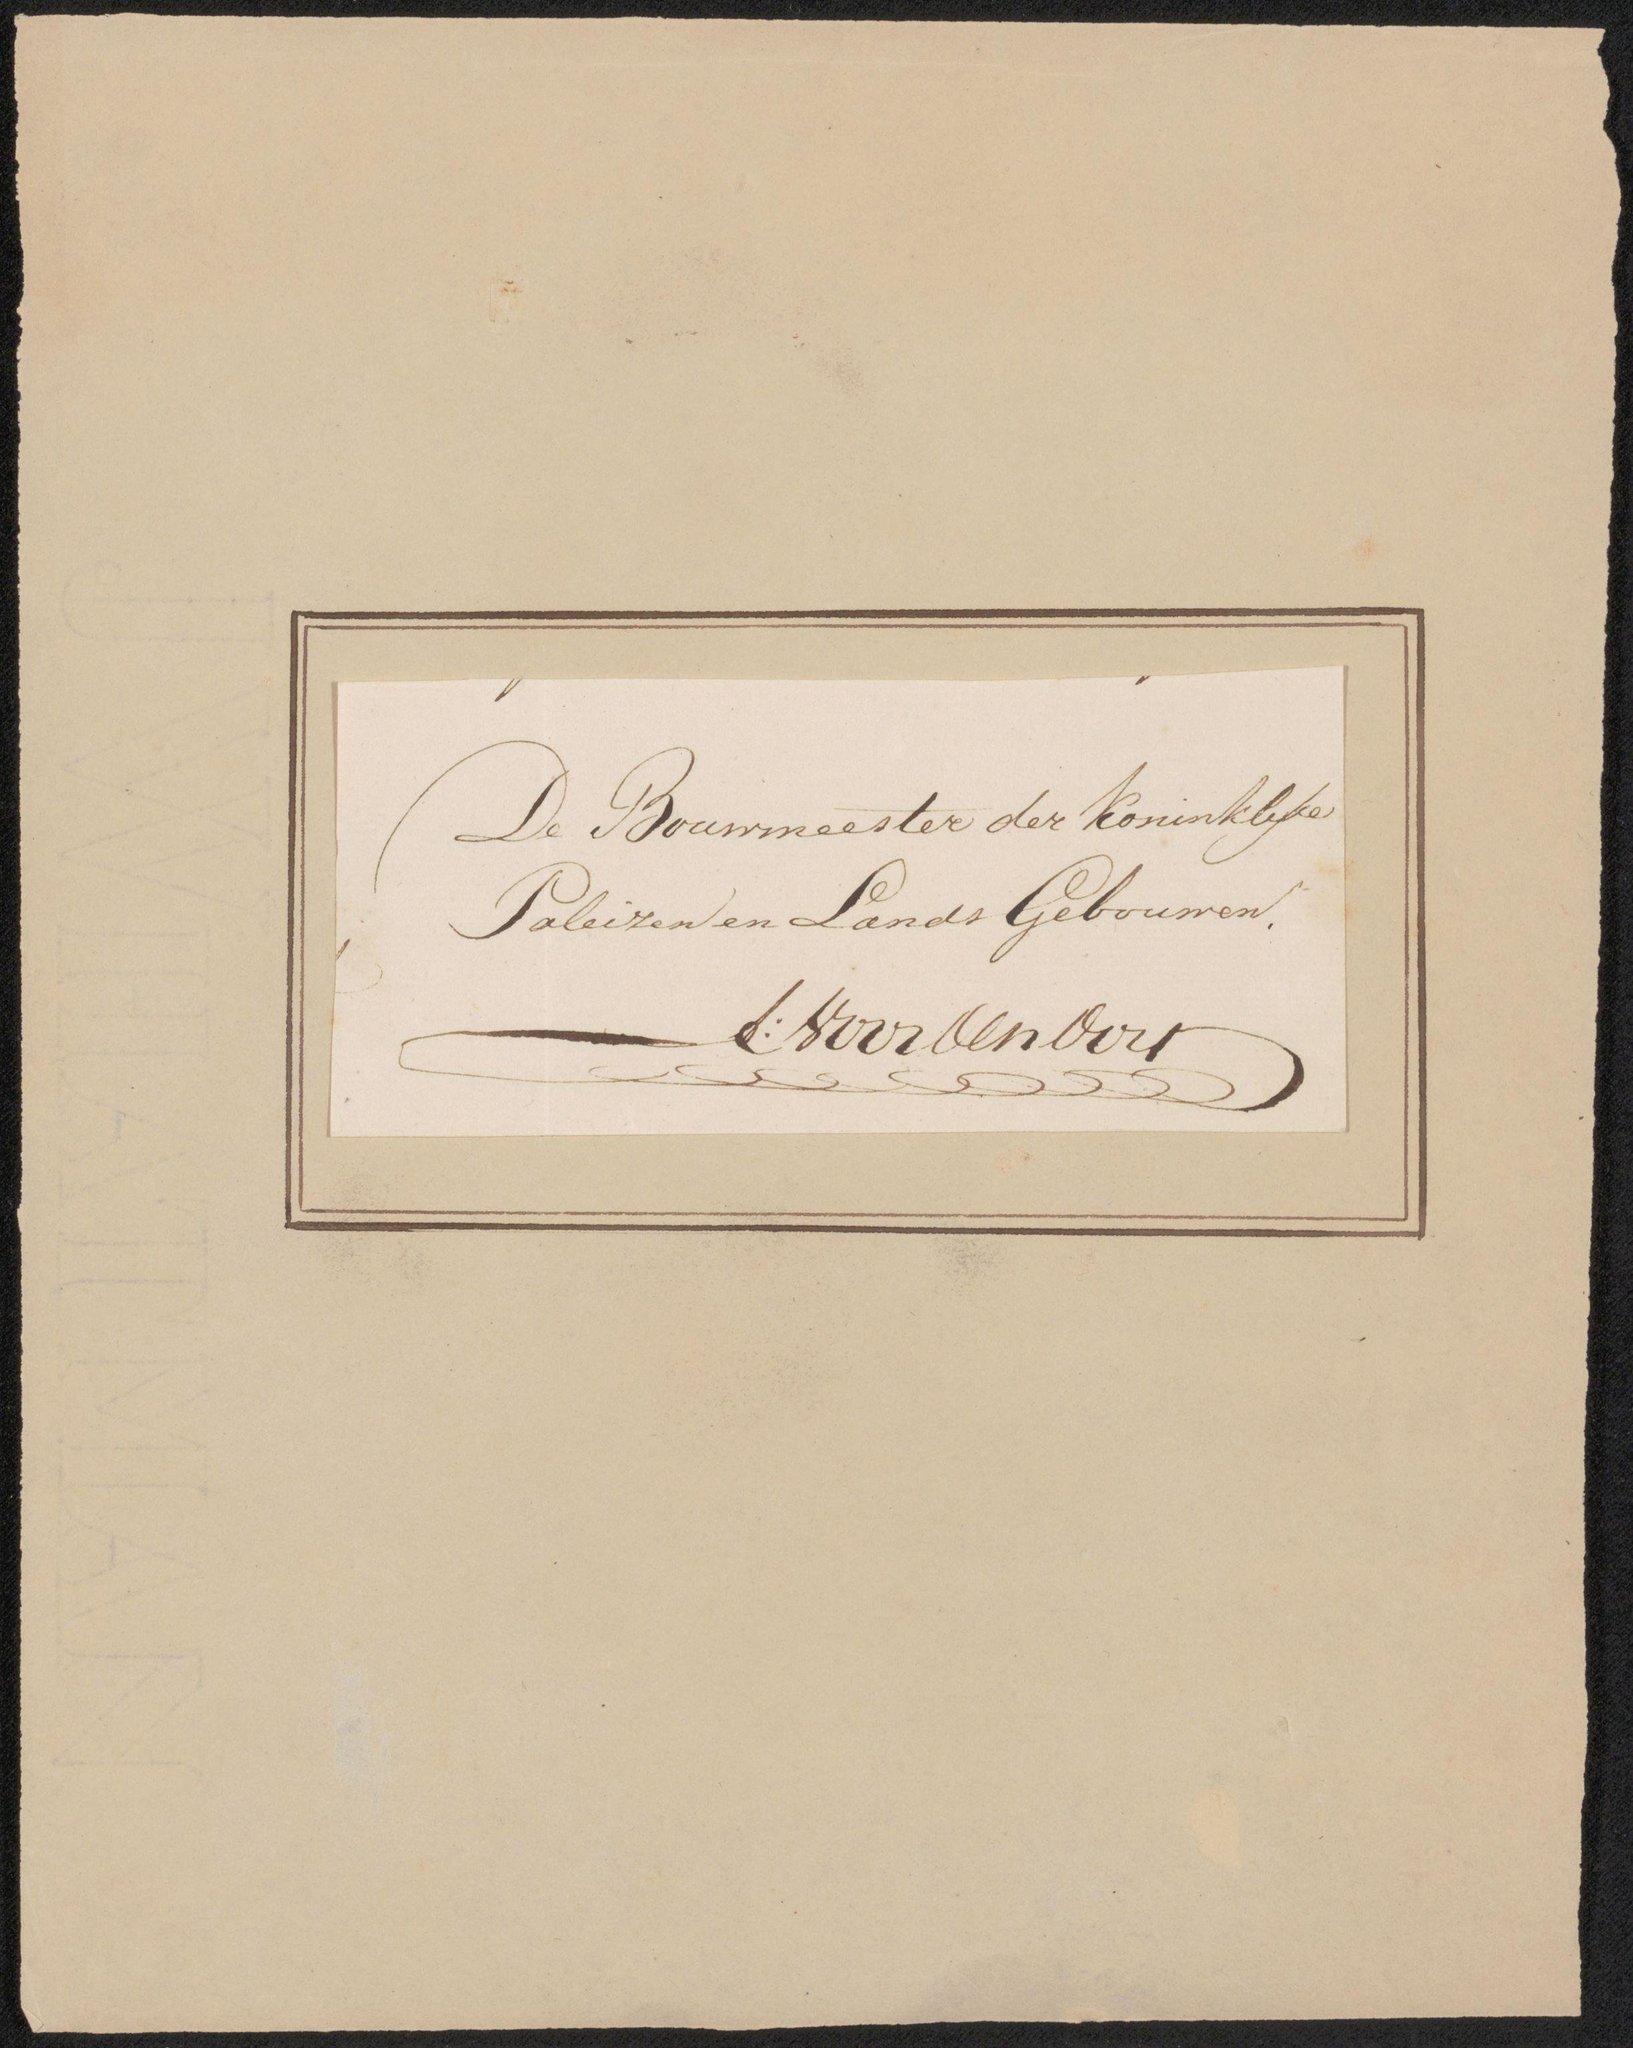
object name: manuscript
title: Handtekening van Adriaan Noordendorp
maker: adriaan noordendorp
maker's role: architect, landmeter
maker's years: 1780-1833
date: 1790-1833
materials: ink, paper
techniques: pen, writing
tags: architecture